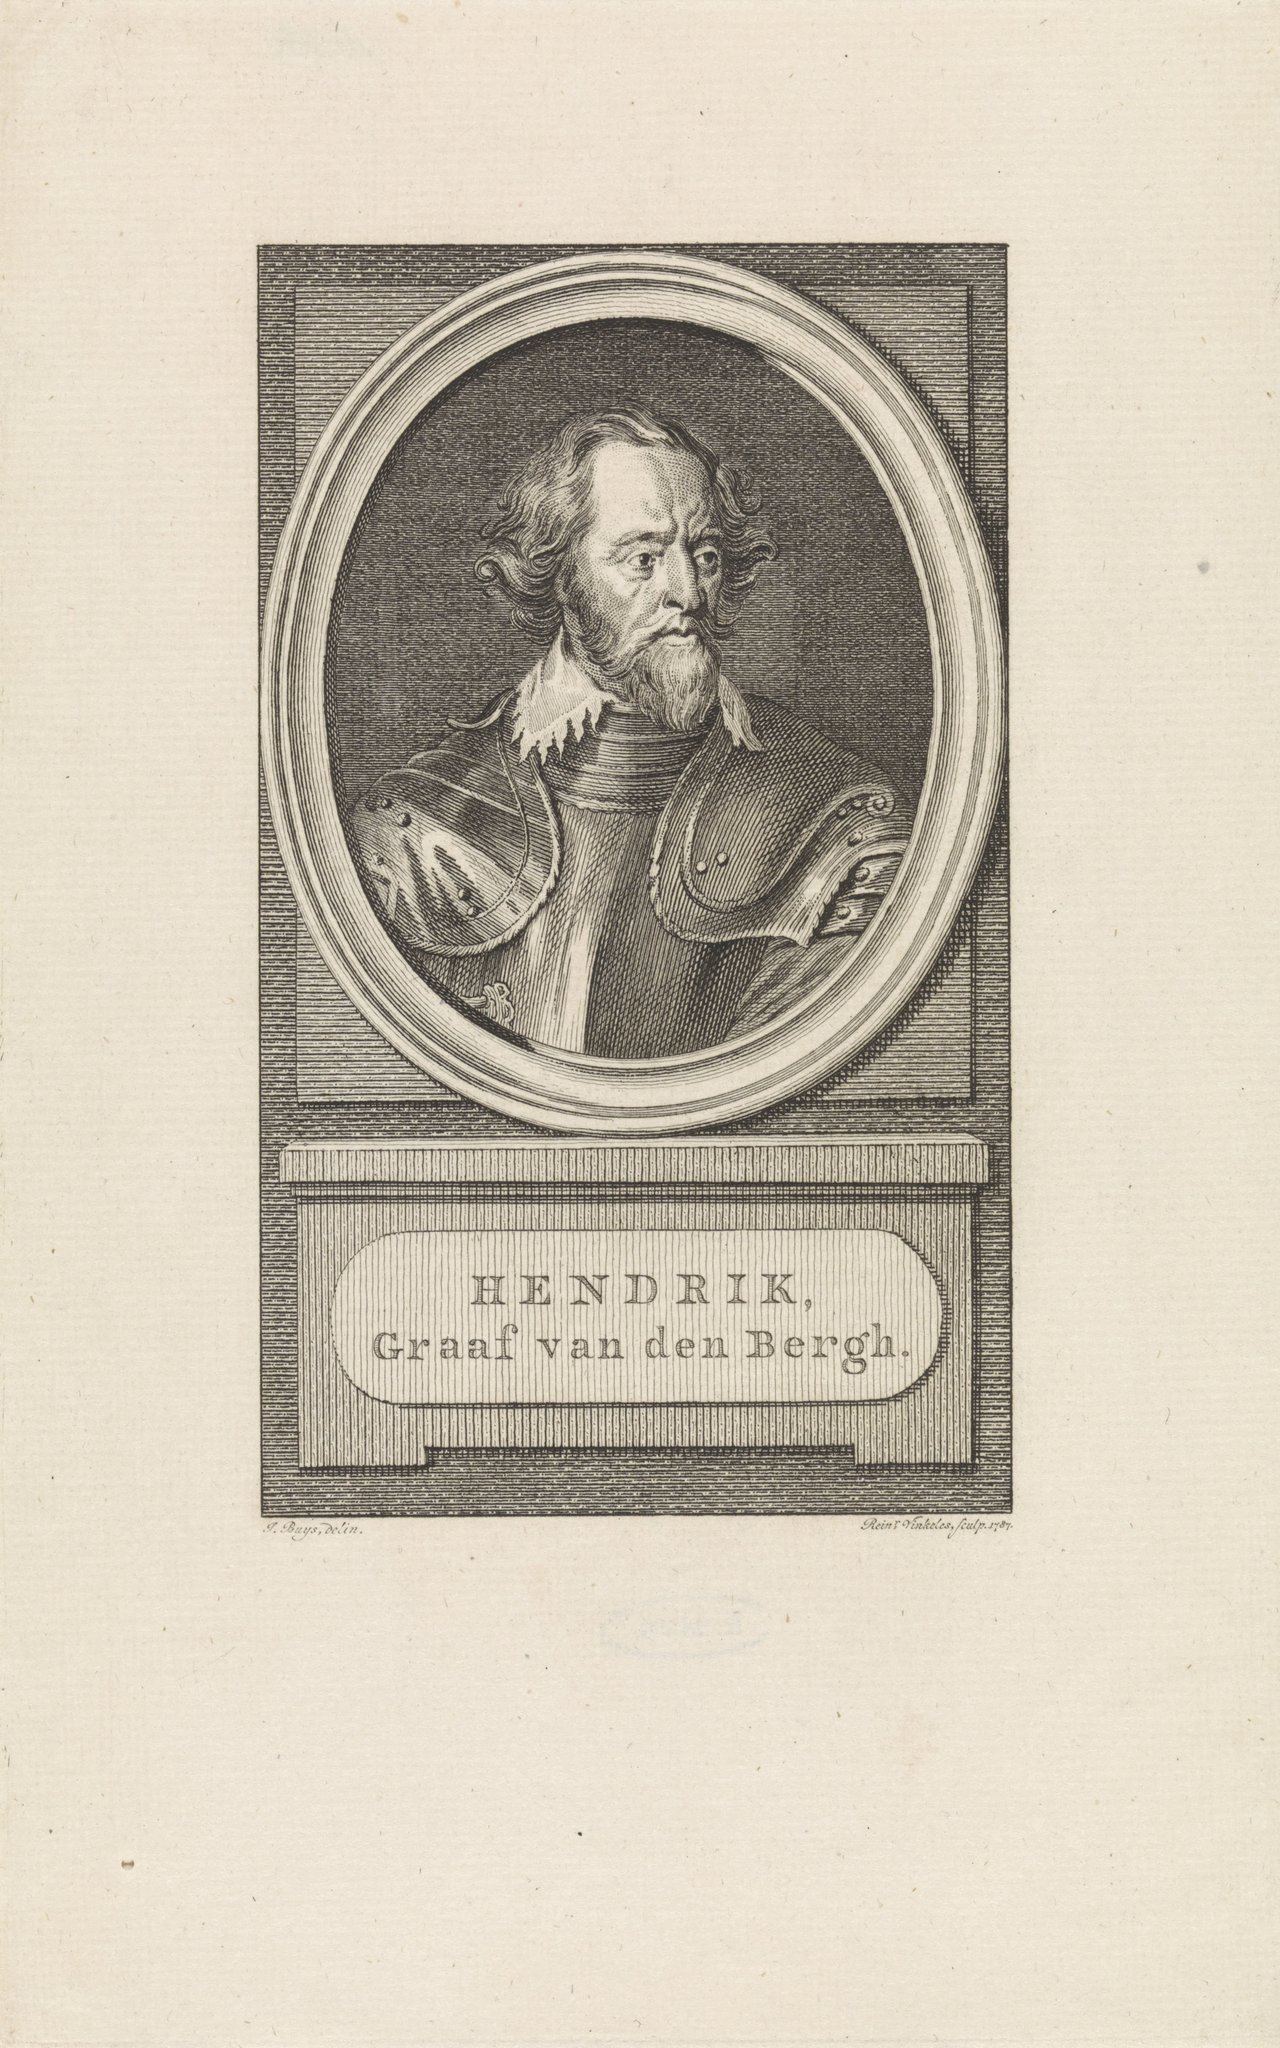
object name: print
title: Portret van Graaf Hendrik van den Bergh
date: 1787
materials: paper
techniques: engraving, etching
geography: amsterdam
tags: hendrik graaf van den bergh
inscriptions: collector's mark: Lugt 2228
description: Andere staat prent gebruikt als boekillustratie in: Kok, Jacobus. Vaderlandsch woordenboek : met kaarten, plaaten en pourtraitten. Amsterdam: Johannes Allart, 1785-1796. Deel VI.